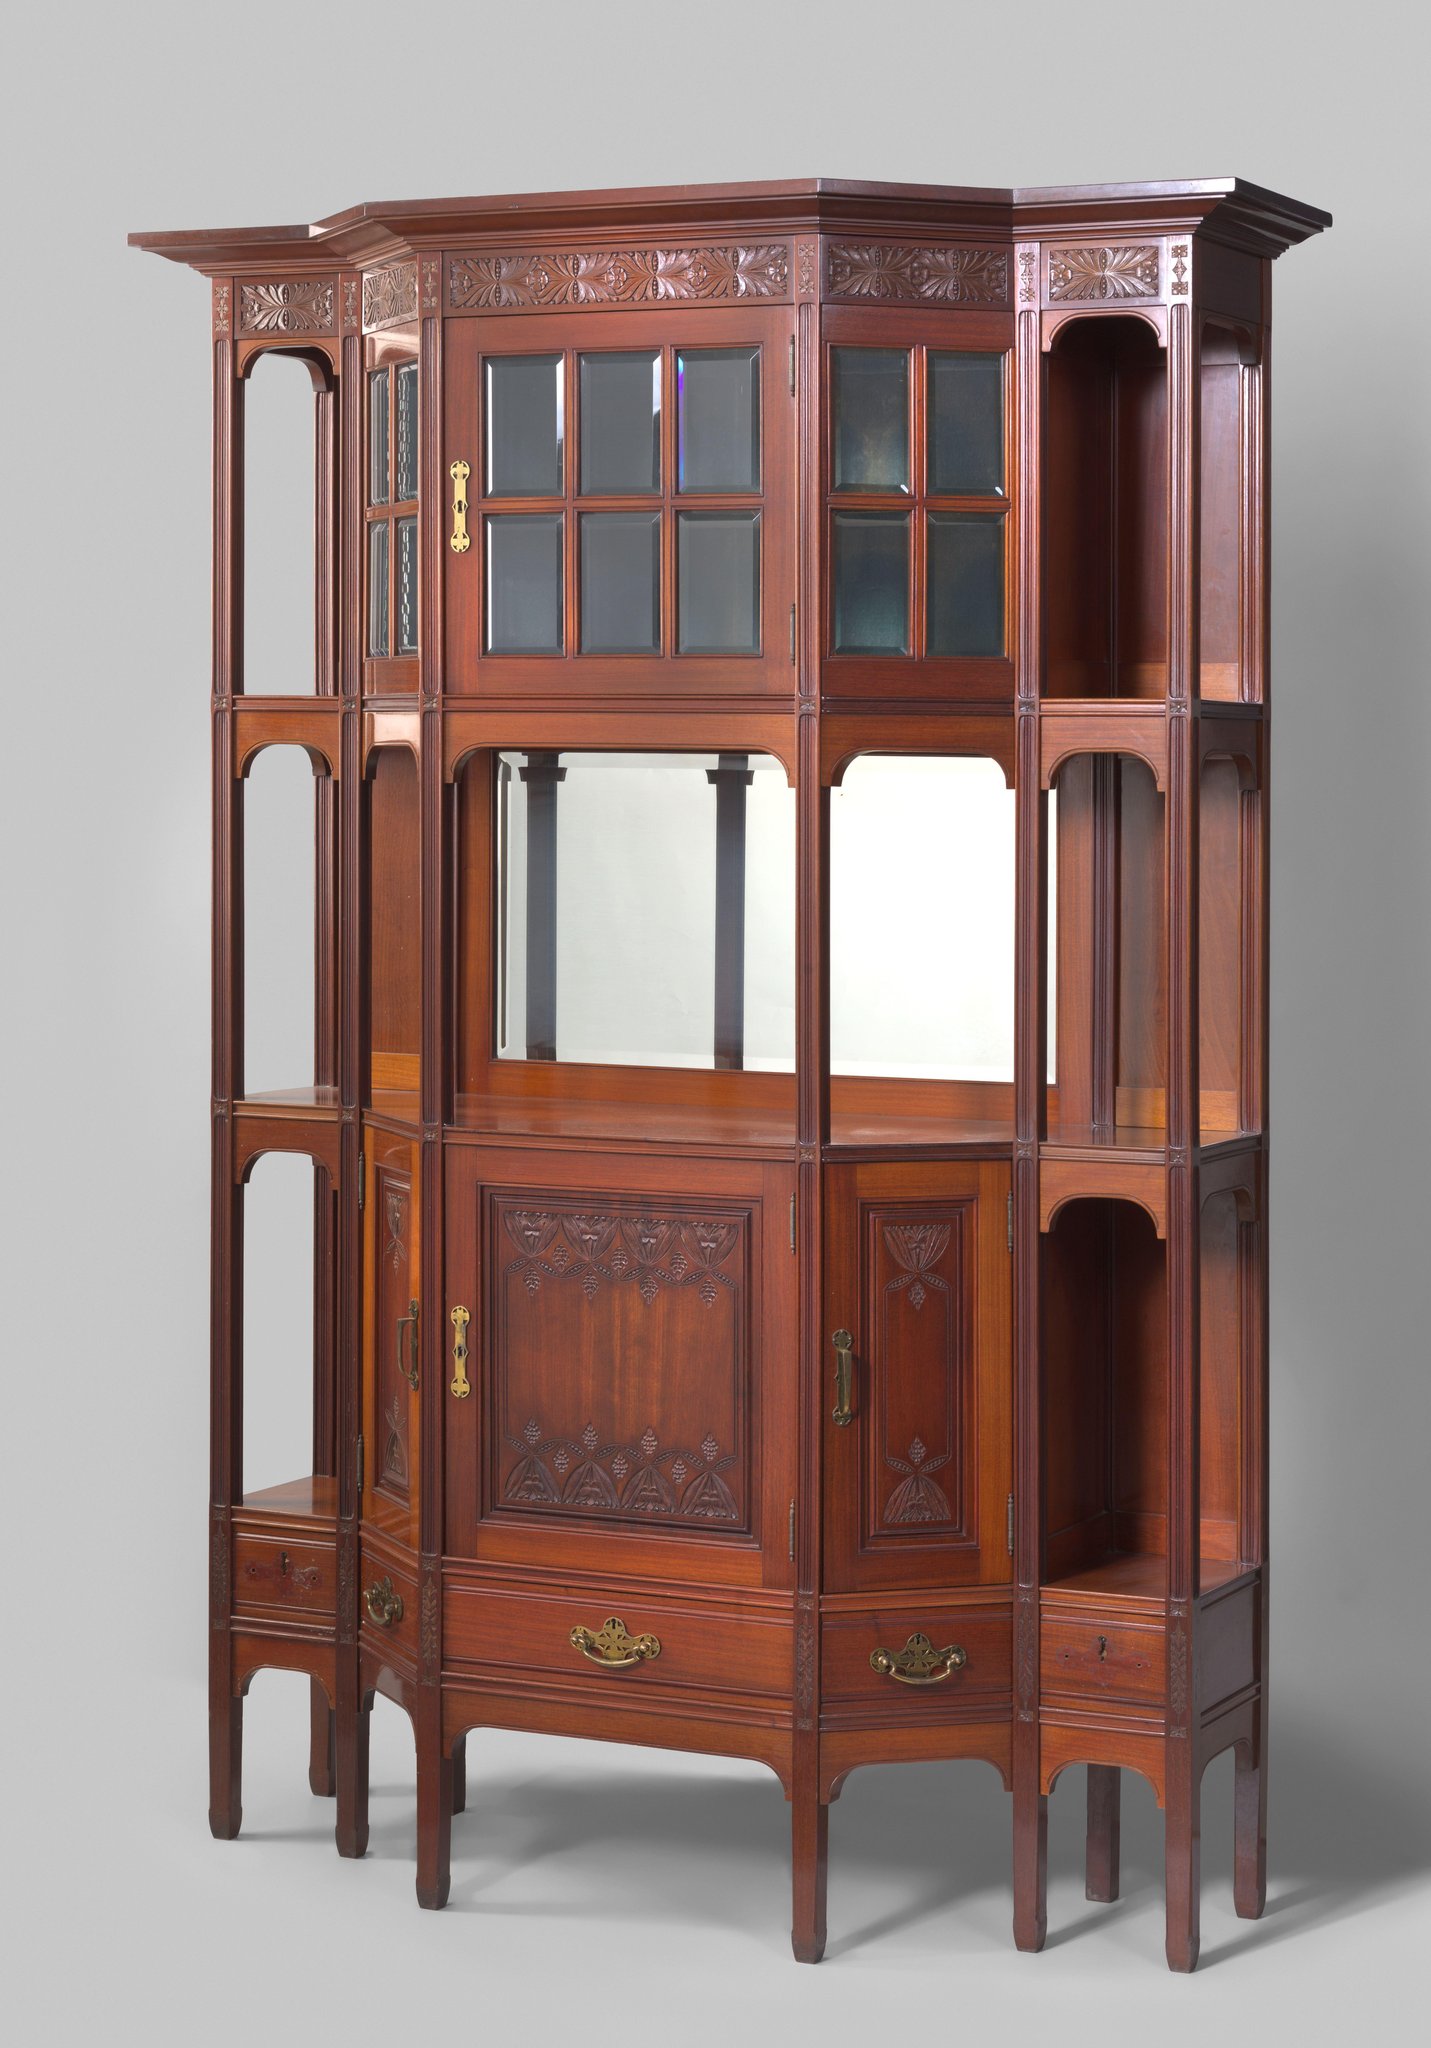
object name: furniture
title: Buffetkast van eikenhout en mahoniehout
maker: Anonymous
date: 1910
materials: brass, glass, wood, textile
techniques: cutting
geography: netherlands